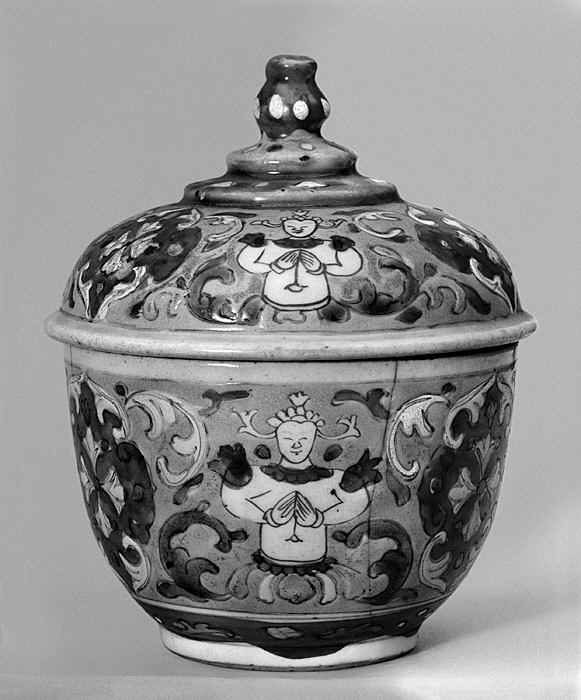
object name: covered bowl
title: Covered bowl with Thai mythical figures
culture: chinese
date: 1801-1900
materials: enamel, porcelain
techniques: overglaze, painting, polychrome